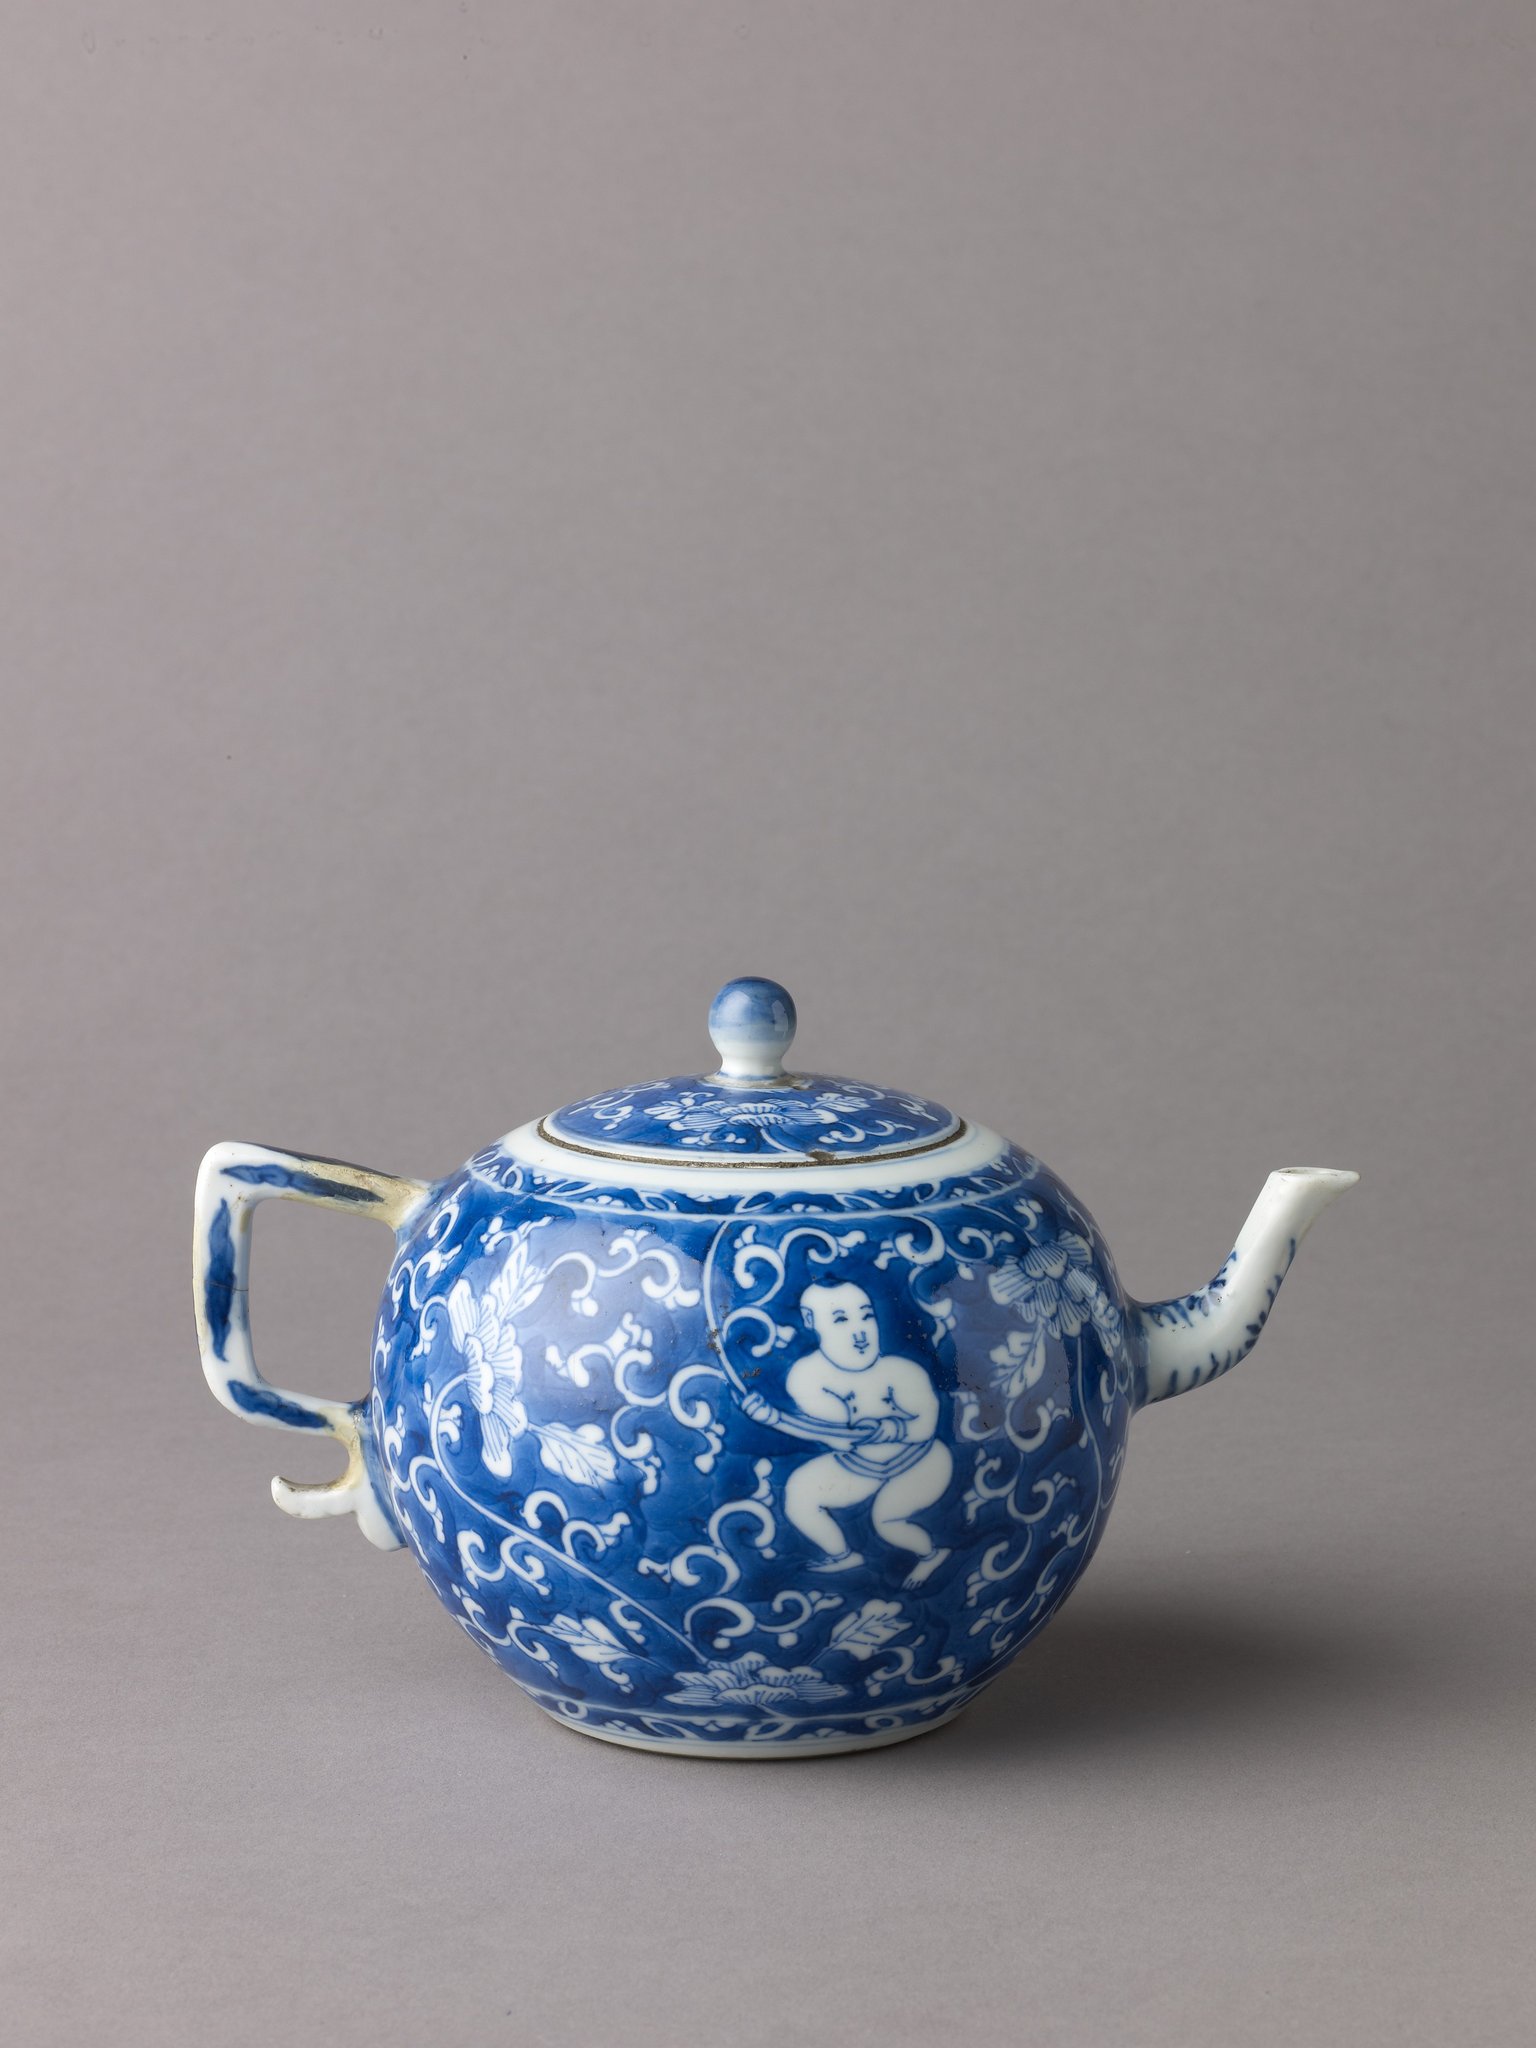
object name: covered winepot or teapot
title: Covered wine pot or teapot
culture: chinese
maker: chinese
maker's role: artist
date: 1662-1722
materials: porcelain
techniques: painting, underglaze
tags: boys